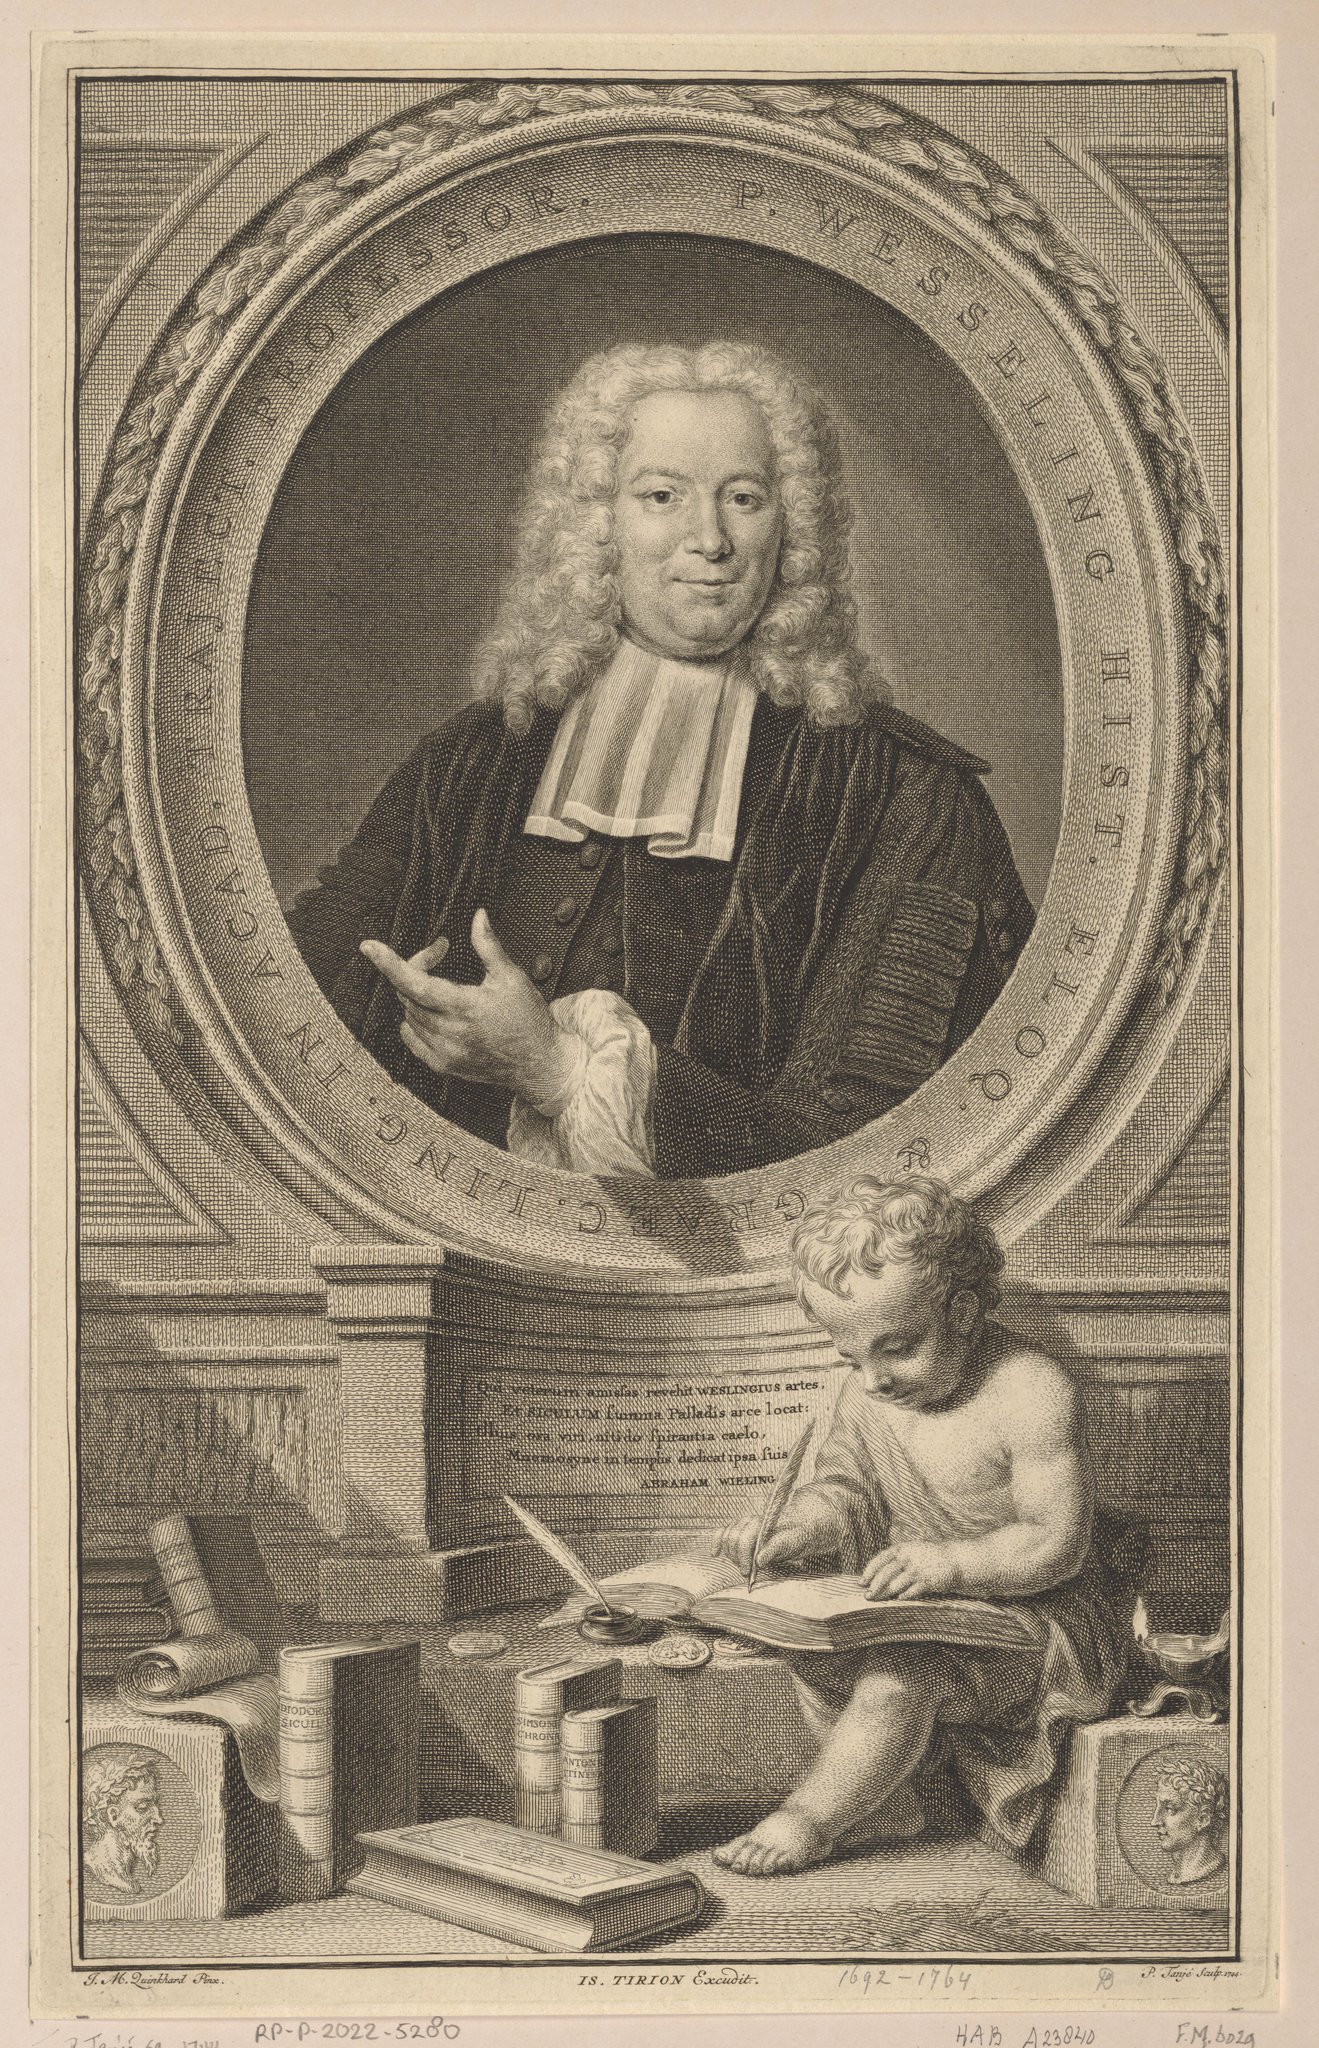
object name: print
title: Portret van Petrus Wesseling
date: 1744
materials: paper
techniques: engraving, etching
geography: amsterdam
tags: writing tools, historical persons, book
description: Met vierregelig onderschrift in het Latijn.